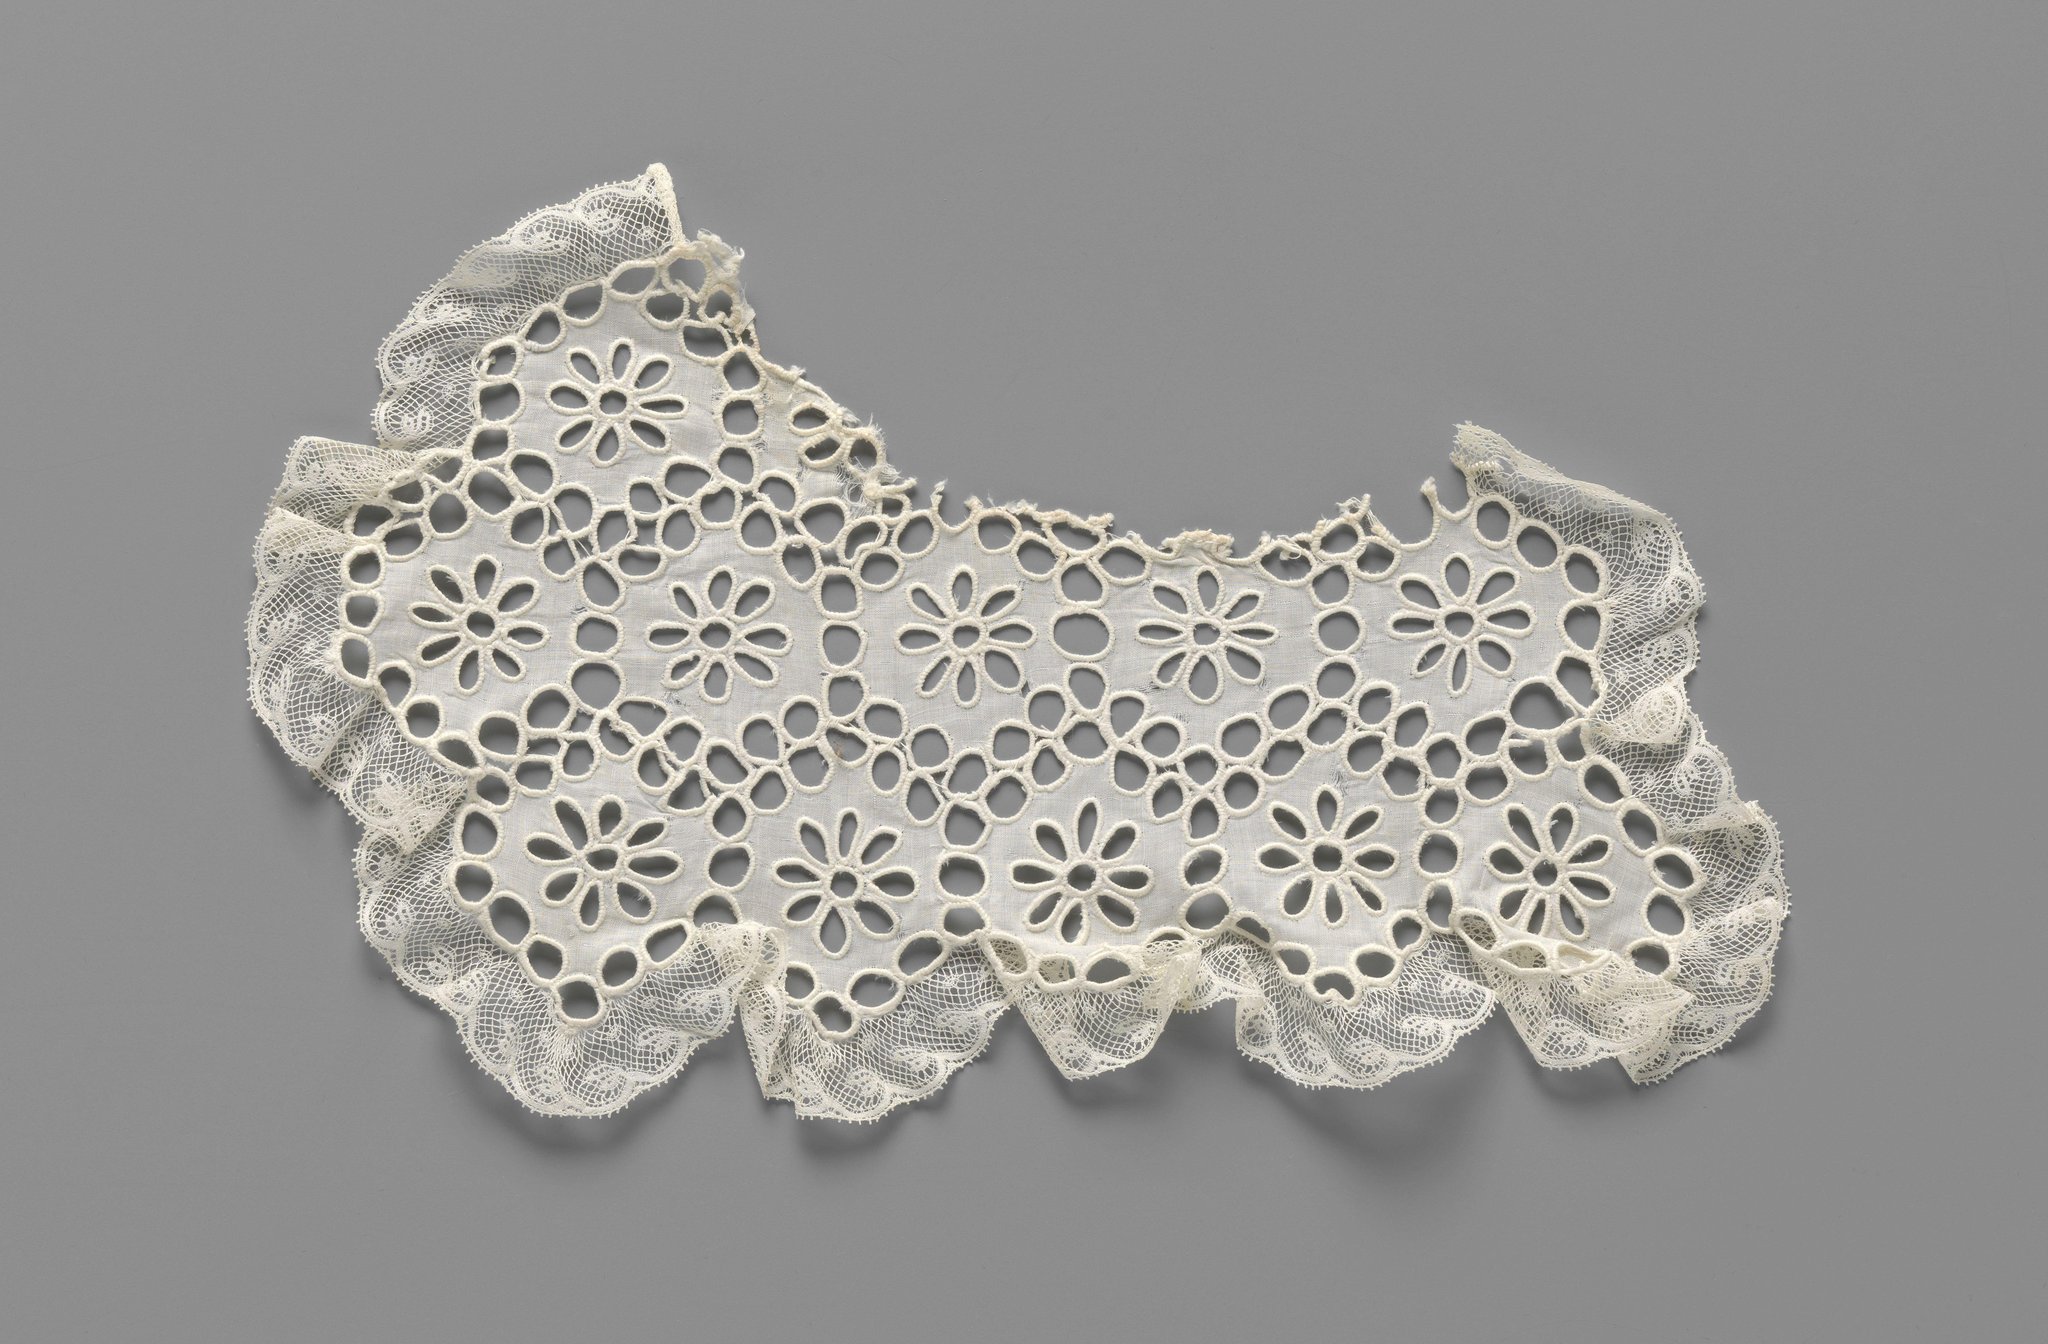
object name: collar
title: Kraag (helft) van batist met aaneengesloten zeshoeken waarin margrieten van kantborduurwerk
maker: c.i. bosch reitz-teding van berkhout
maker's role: kantwerkster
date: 1870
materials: textile, cotton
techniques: lace, weave, embroidery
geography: amsterdam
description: Kraag (helft) van naturelkleurig batist met kantborduurwerk: Engels borduurwerk. De andere helft betreft BK-1978-714-B. Rechhoekig model met afgeronde hoeken en iets holle bovenzijde. Het patroon bestaat uit een rij aaneengesloten zeshoeken gemaakt met opengewerkte cirkeltjes, met in elke zeshoek een opengewerkte margriet. De schulpenrand volgt het patroon met de zeshoeken en is langs drie zijden afgewerkt met een gerimpeld aangezet strookje machinale kant: machinale Valenciennes-kant. Het borduurwerk is gemaakt rond 1870, de kraag rond 1910.